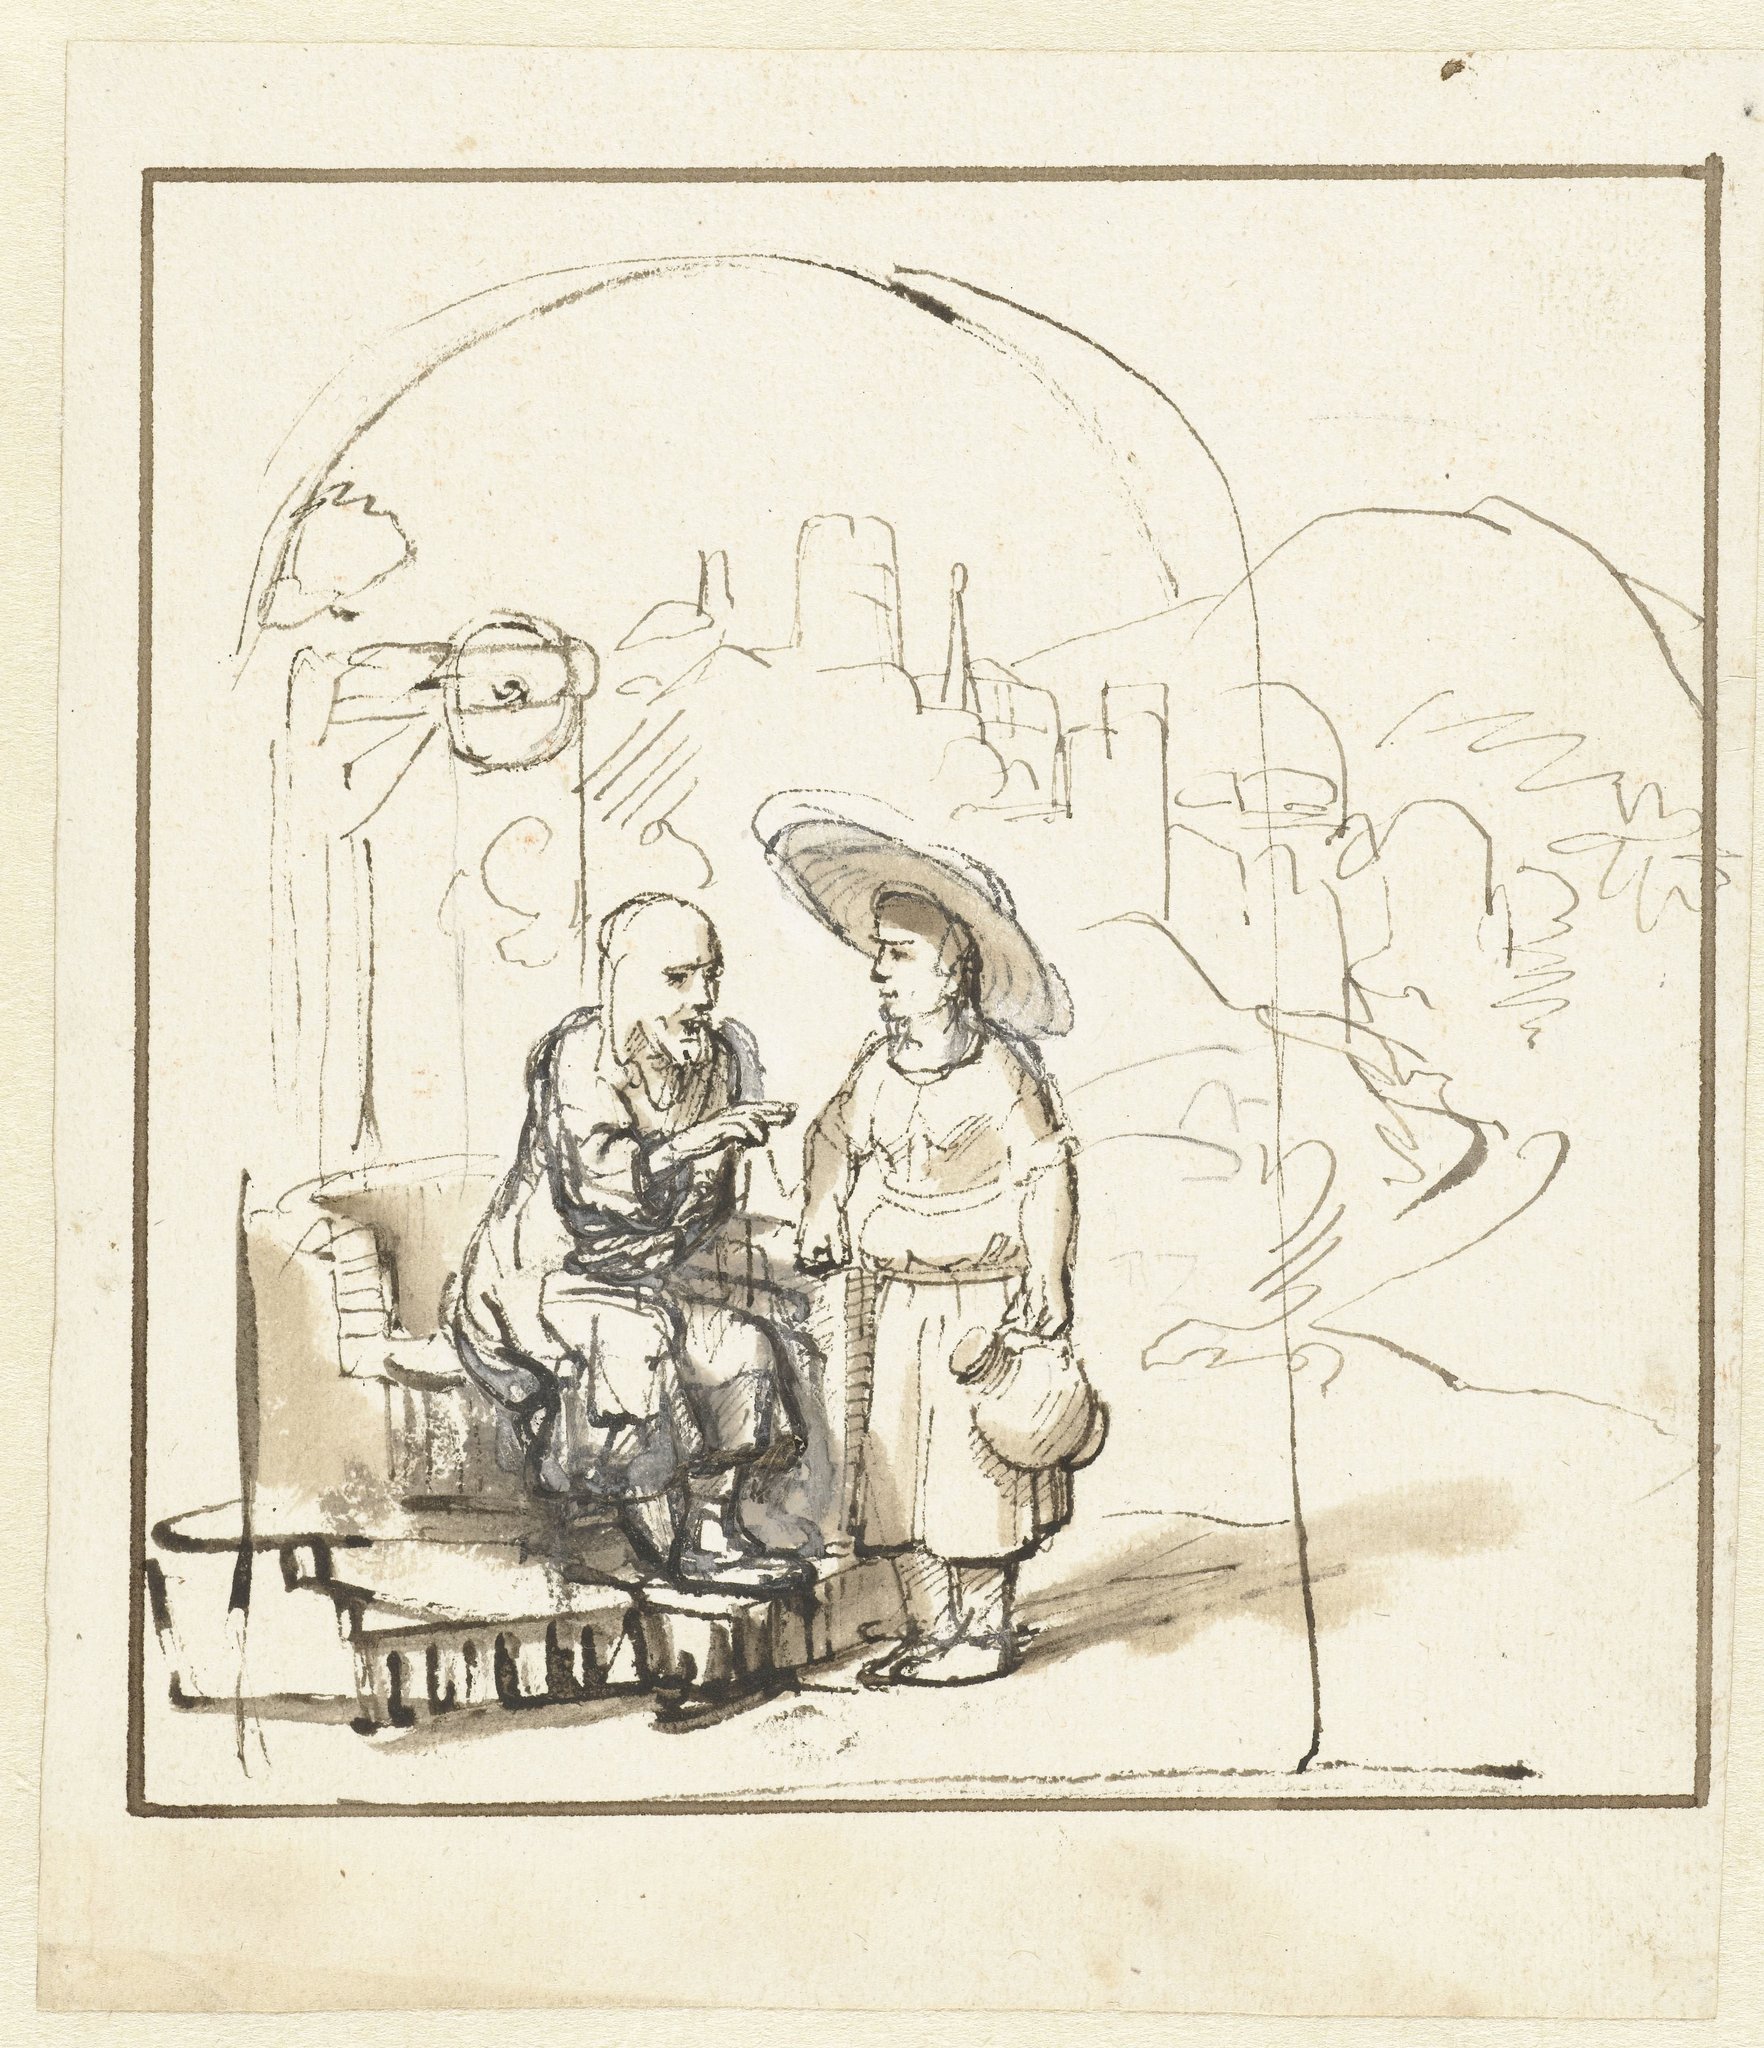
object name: drawing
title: Christ and the Woman of Samaria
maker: nicolaes maes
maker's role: draughtsman, painter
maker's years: 1634-1693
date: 1650-1655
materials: paint, ink, paper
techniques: brush, pen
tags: christ and the woman of samaria: sitting at jacob's well he asks her for a drink from her jug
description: Afkomstig uit een album met losliggende tekeningen van met name Matthijs Balen.